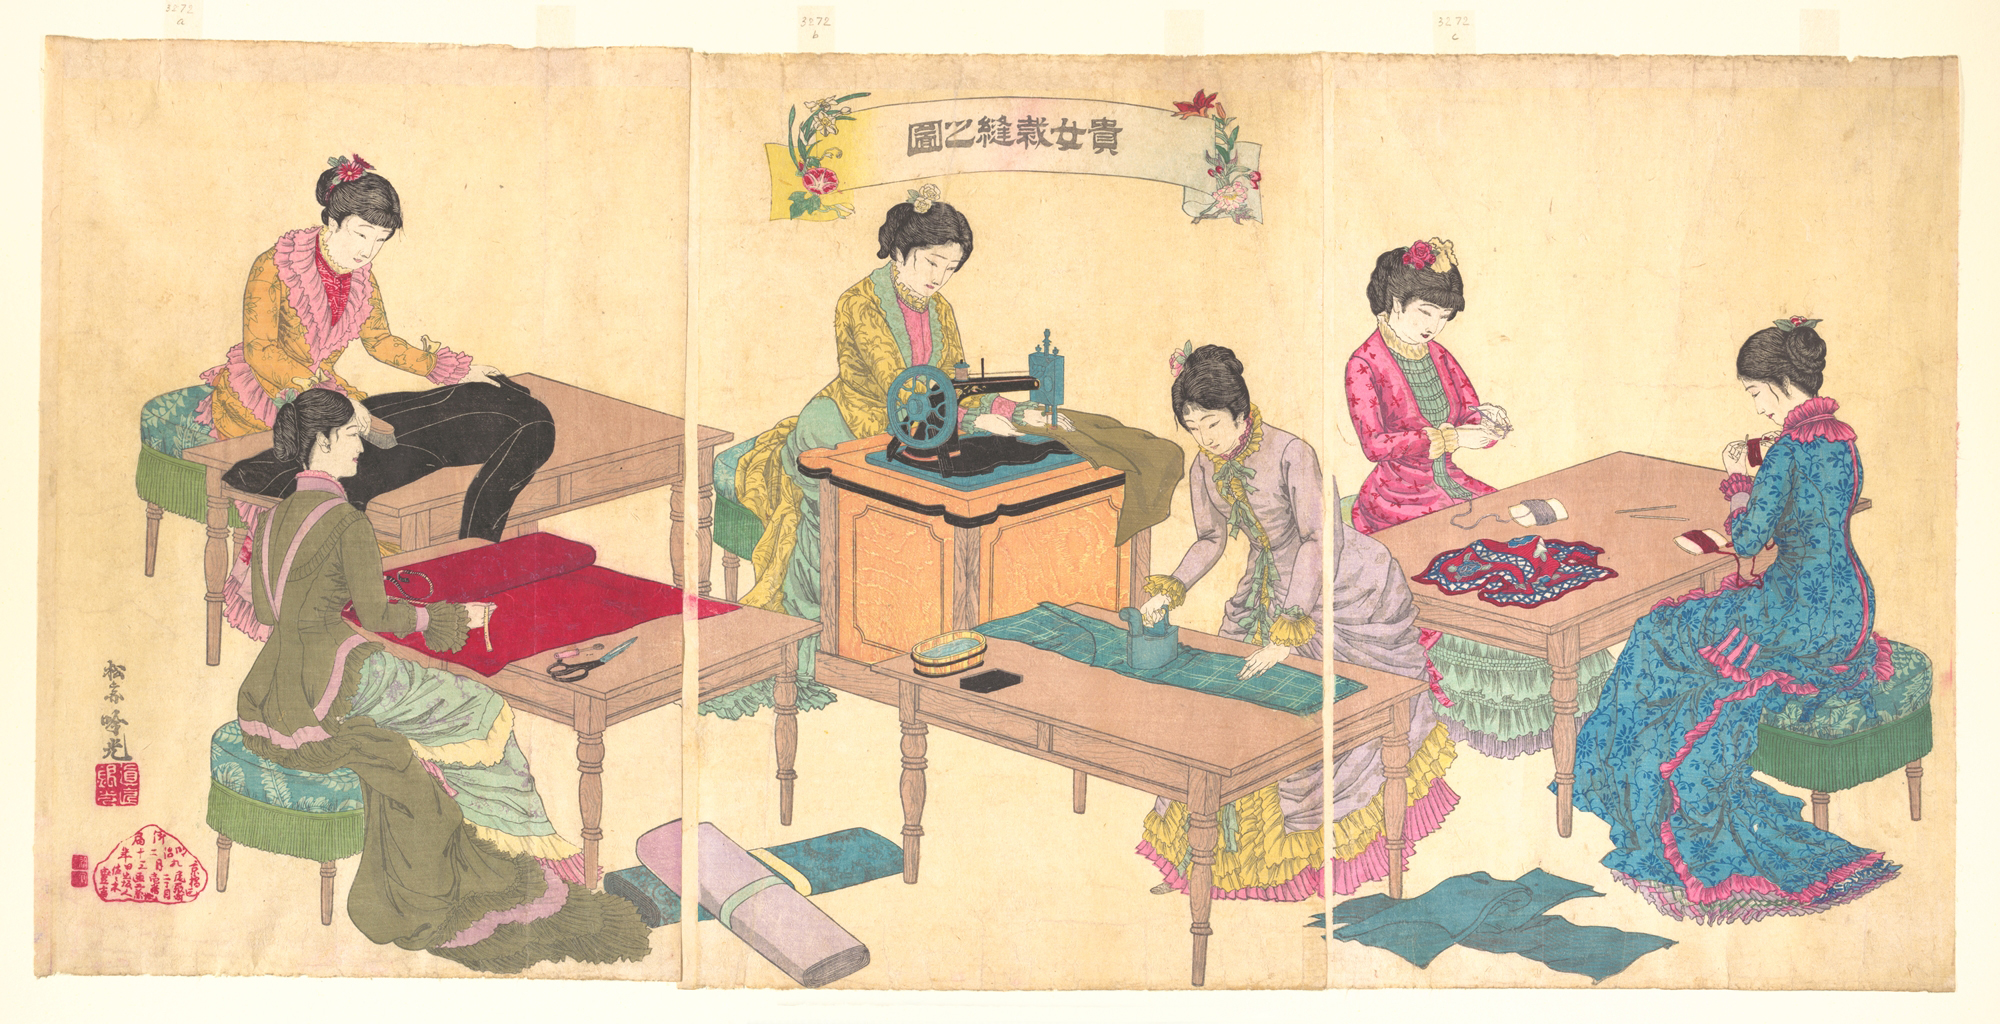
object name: print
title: Ladies Sewing (Kijo saihō no zu)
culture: japanese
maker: adachi ginkō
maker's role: artist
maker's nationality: japanese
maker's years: 1853-1902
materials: ink, paper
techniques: nishiki e, woodblock print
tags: women,sewing,irons